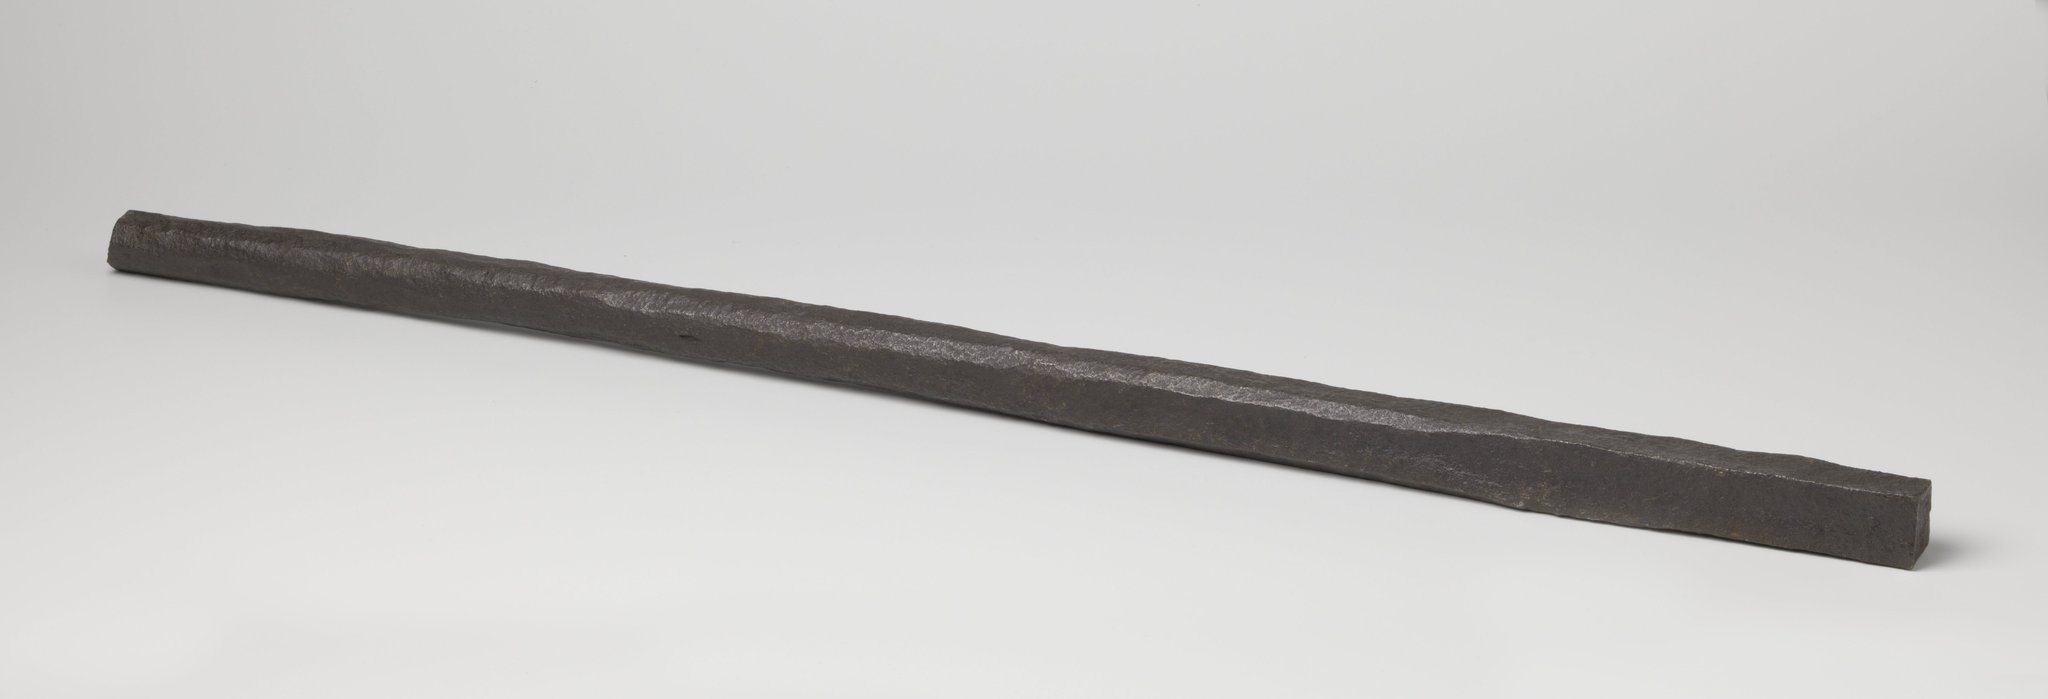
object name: spaak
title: Lange spaak van ijzer met ronde doorsnede eindigend in rechthoekig stuk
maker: Anonymous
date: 1590-1596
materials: iron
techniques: forging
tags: willem barendsz., amsterdam, jacob van heemskerck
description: Lange spaak van ijzer met ronde doorsnede eindigend in rechthoekig stuk. Behorend bij NG-NM-7662-1, vormden samen één. Deze spaak werd te Hammerfest doorgezaagd, omdat men meende dat het de loop van een vuurroer was. De spaak werd echter van massief ijzer bevonden. Volgens B. Kist is dit een handspaak.